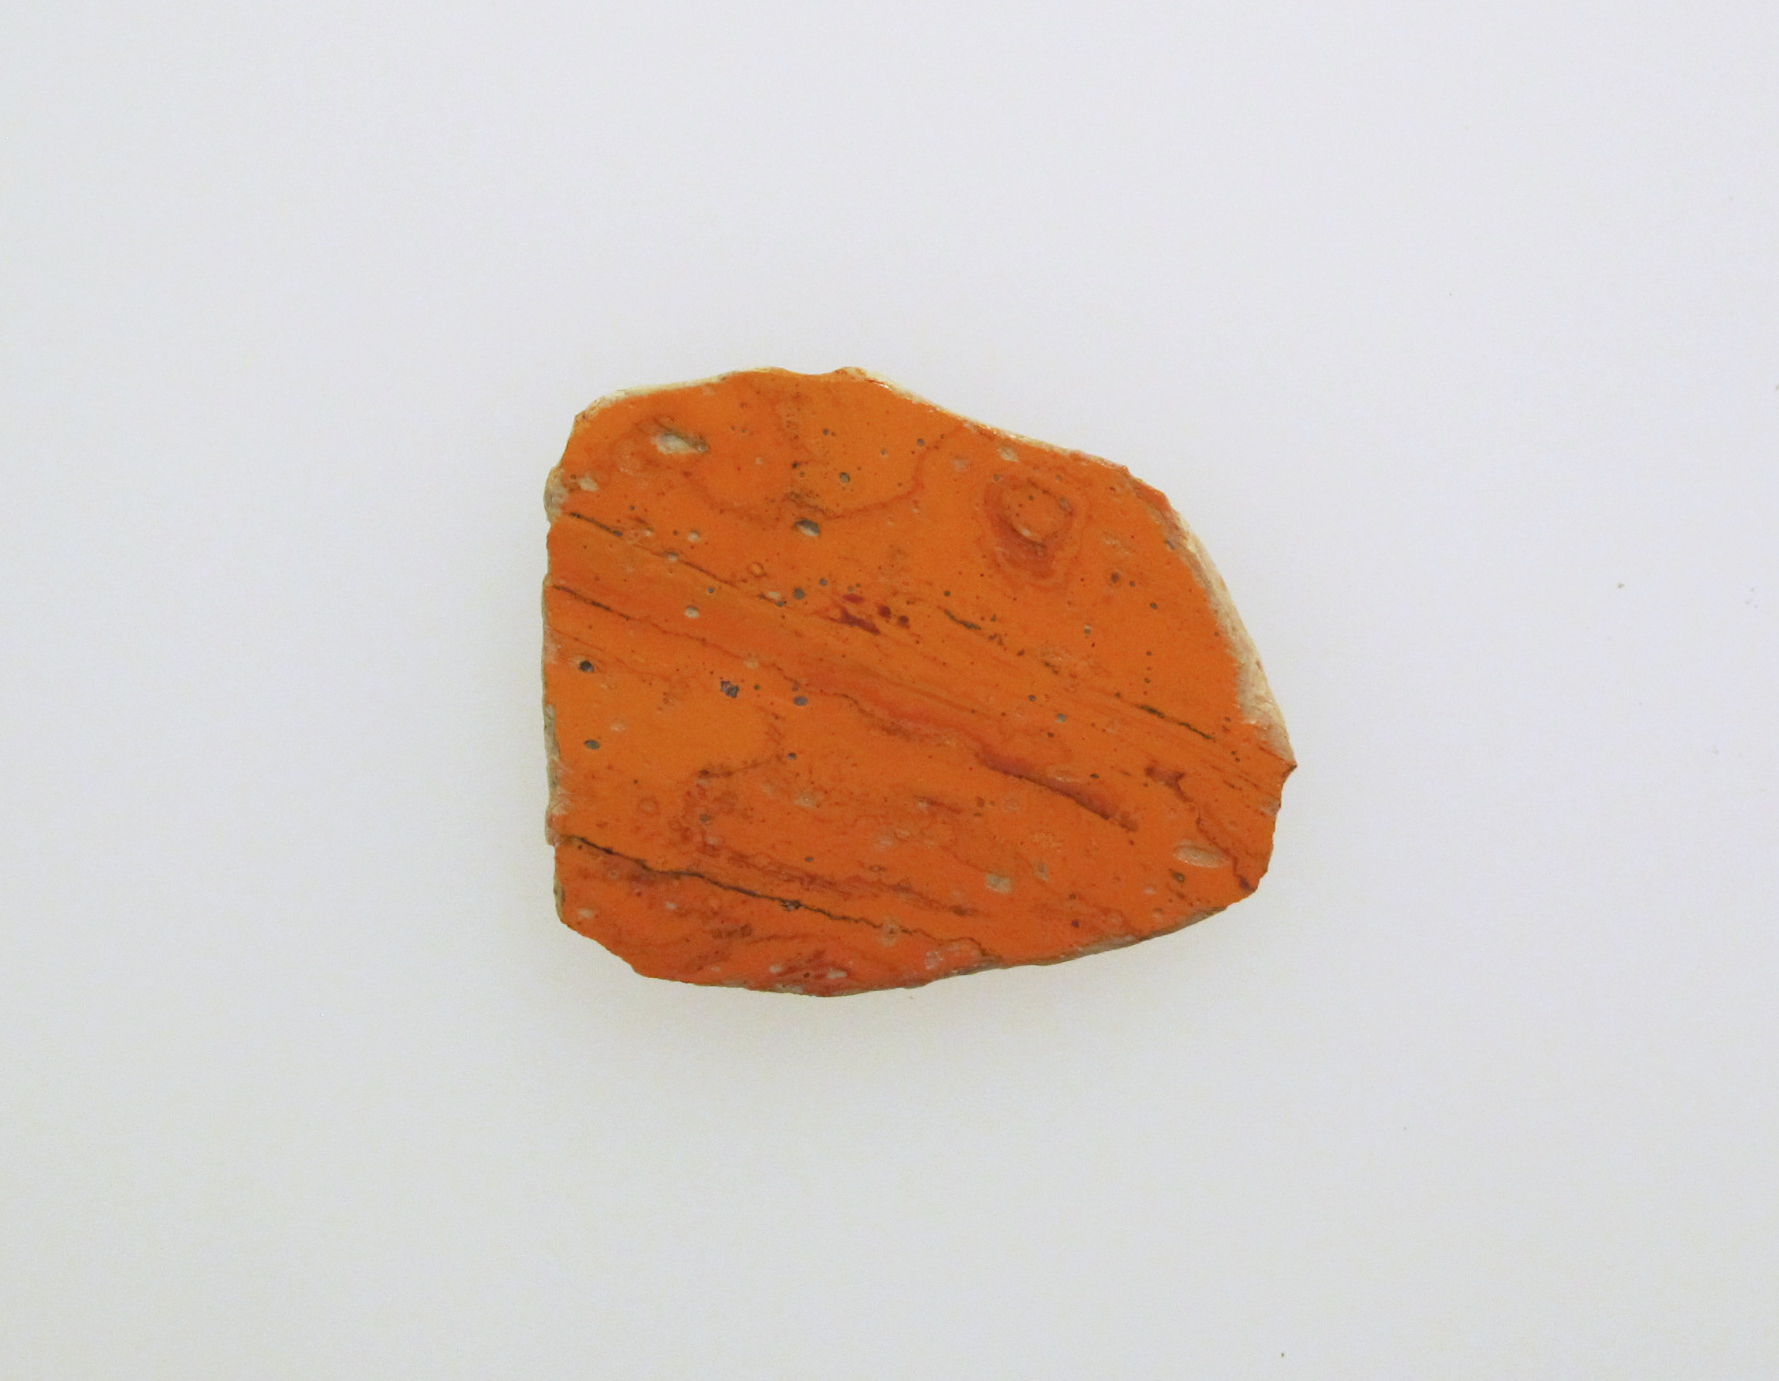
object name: fragment, marbled mosaic inlay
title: Glass marbled mosaic inlay fragment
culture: roman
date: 1-50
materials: glass